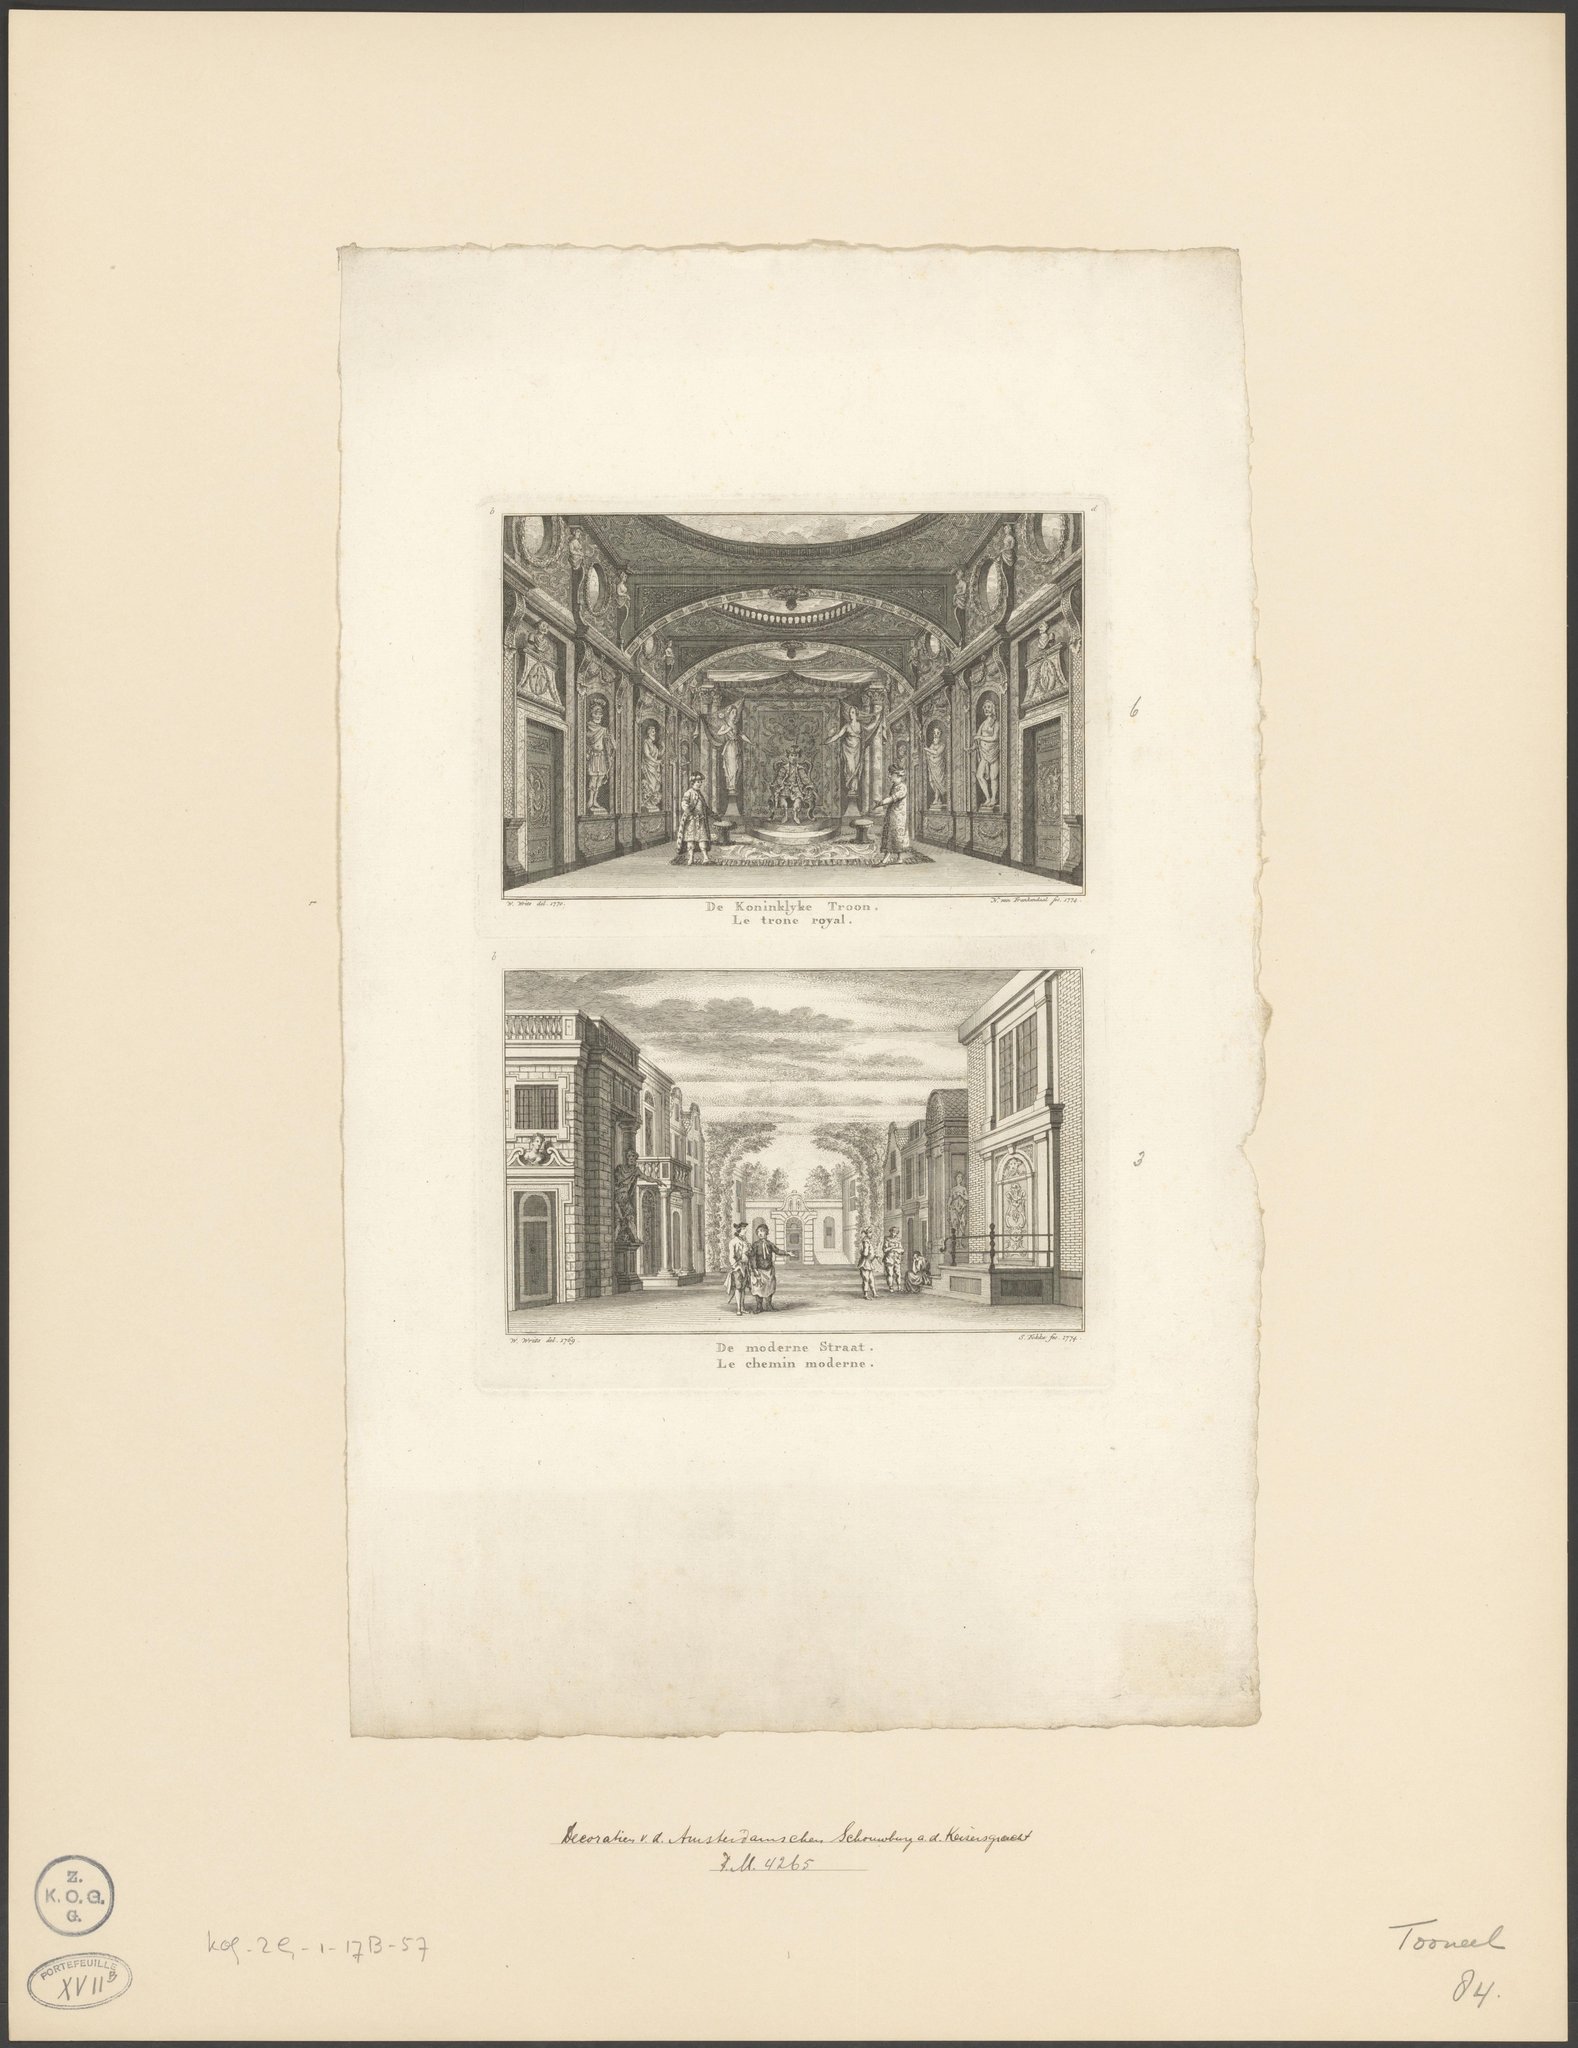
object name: print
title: Twee theaterdecors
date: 1774-1804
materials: paper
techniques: engraving, etching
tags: theatre, theatrical performance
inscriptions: collector's mark: Lugt 1641, stamp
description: Bovenaan de bovenste prent genummerd: b/d. Bovenaan de onderste prent genummerd: b/e. Onderwerpsrubrieken binnen de Atlas Zeden en Gewoonten: Schoone kunsten, Tooneel, Schouwburg op de Keizersgracht (1637 – 1772).